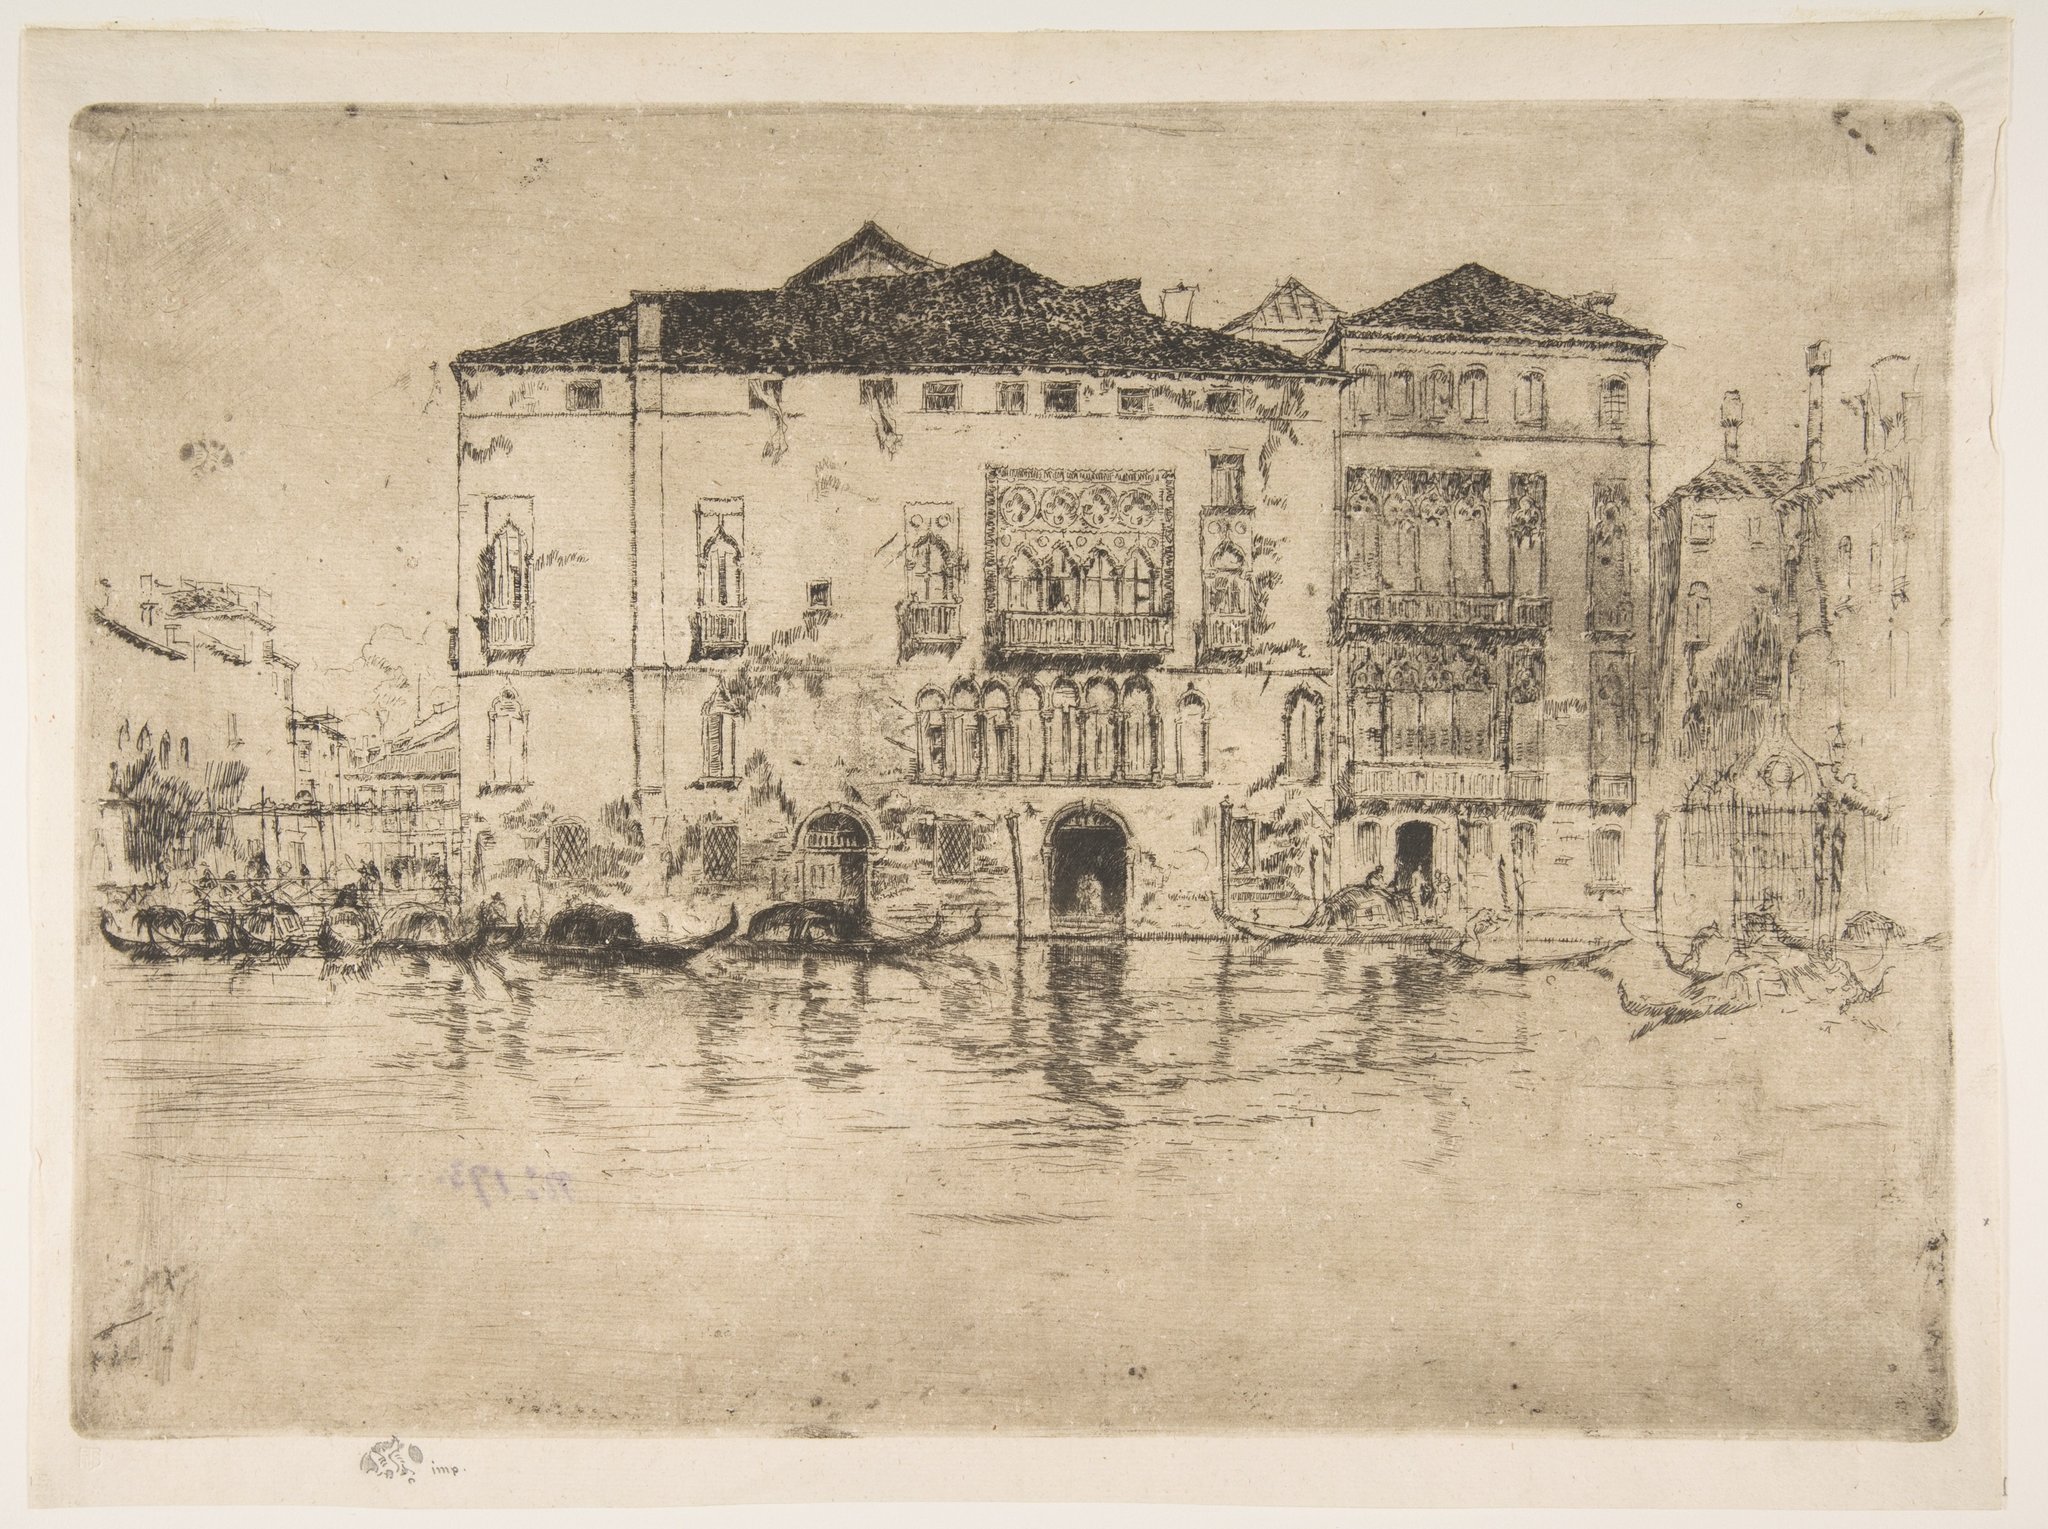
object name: print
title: The Palaces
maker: james mcneill whistler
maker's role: artist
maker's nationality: american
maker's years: 1834-1903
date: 1879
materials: ink, paper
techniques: drypoint, etching, printing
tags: palaces,boats,venice